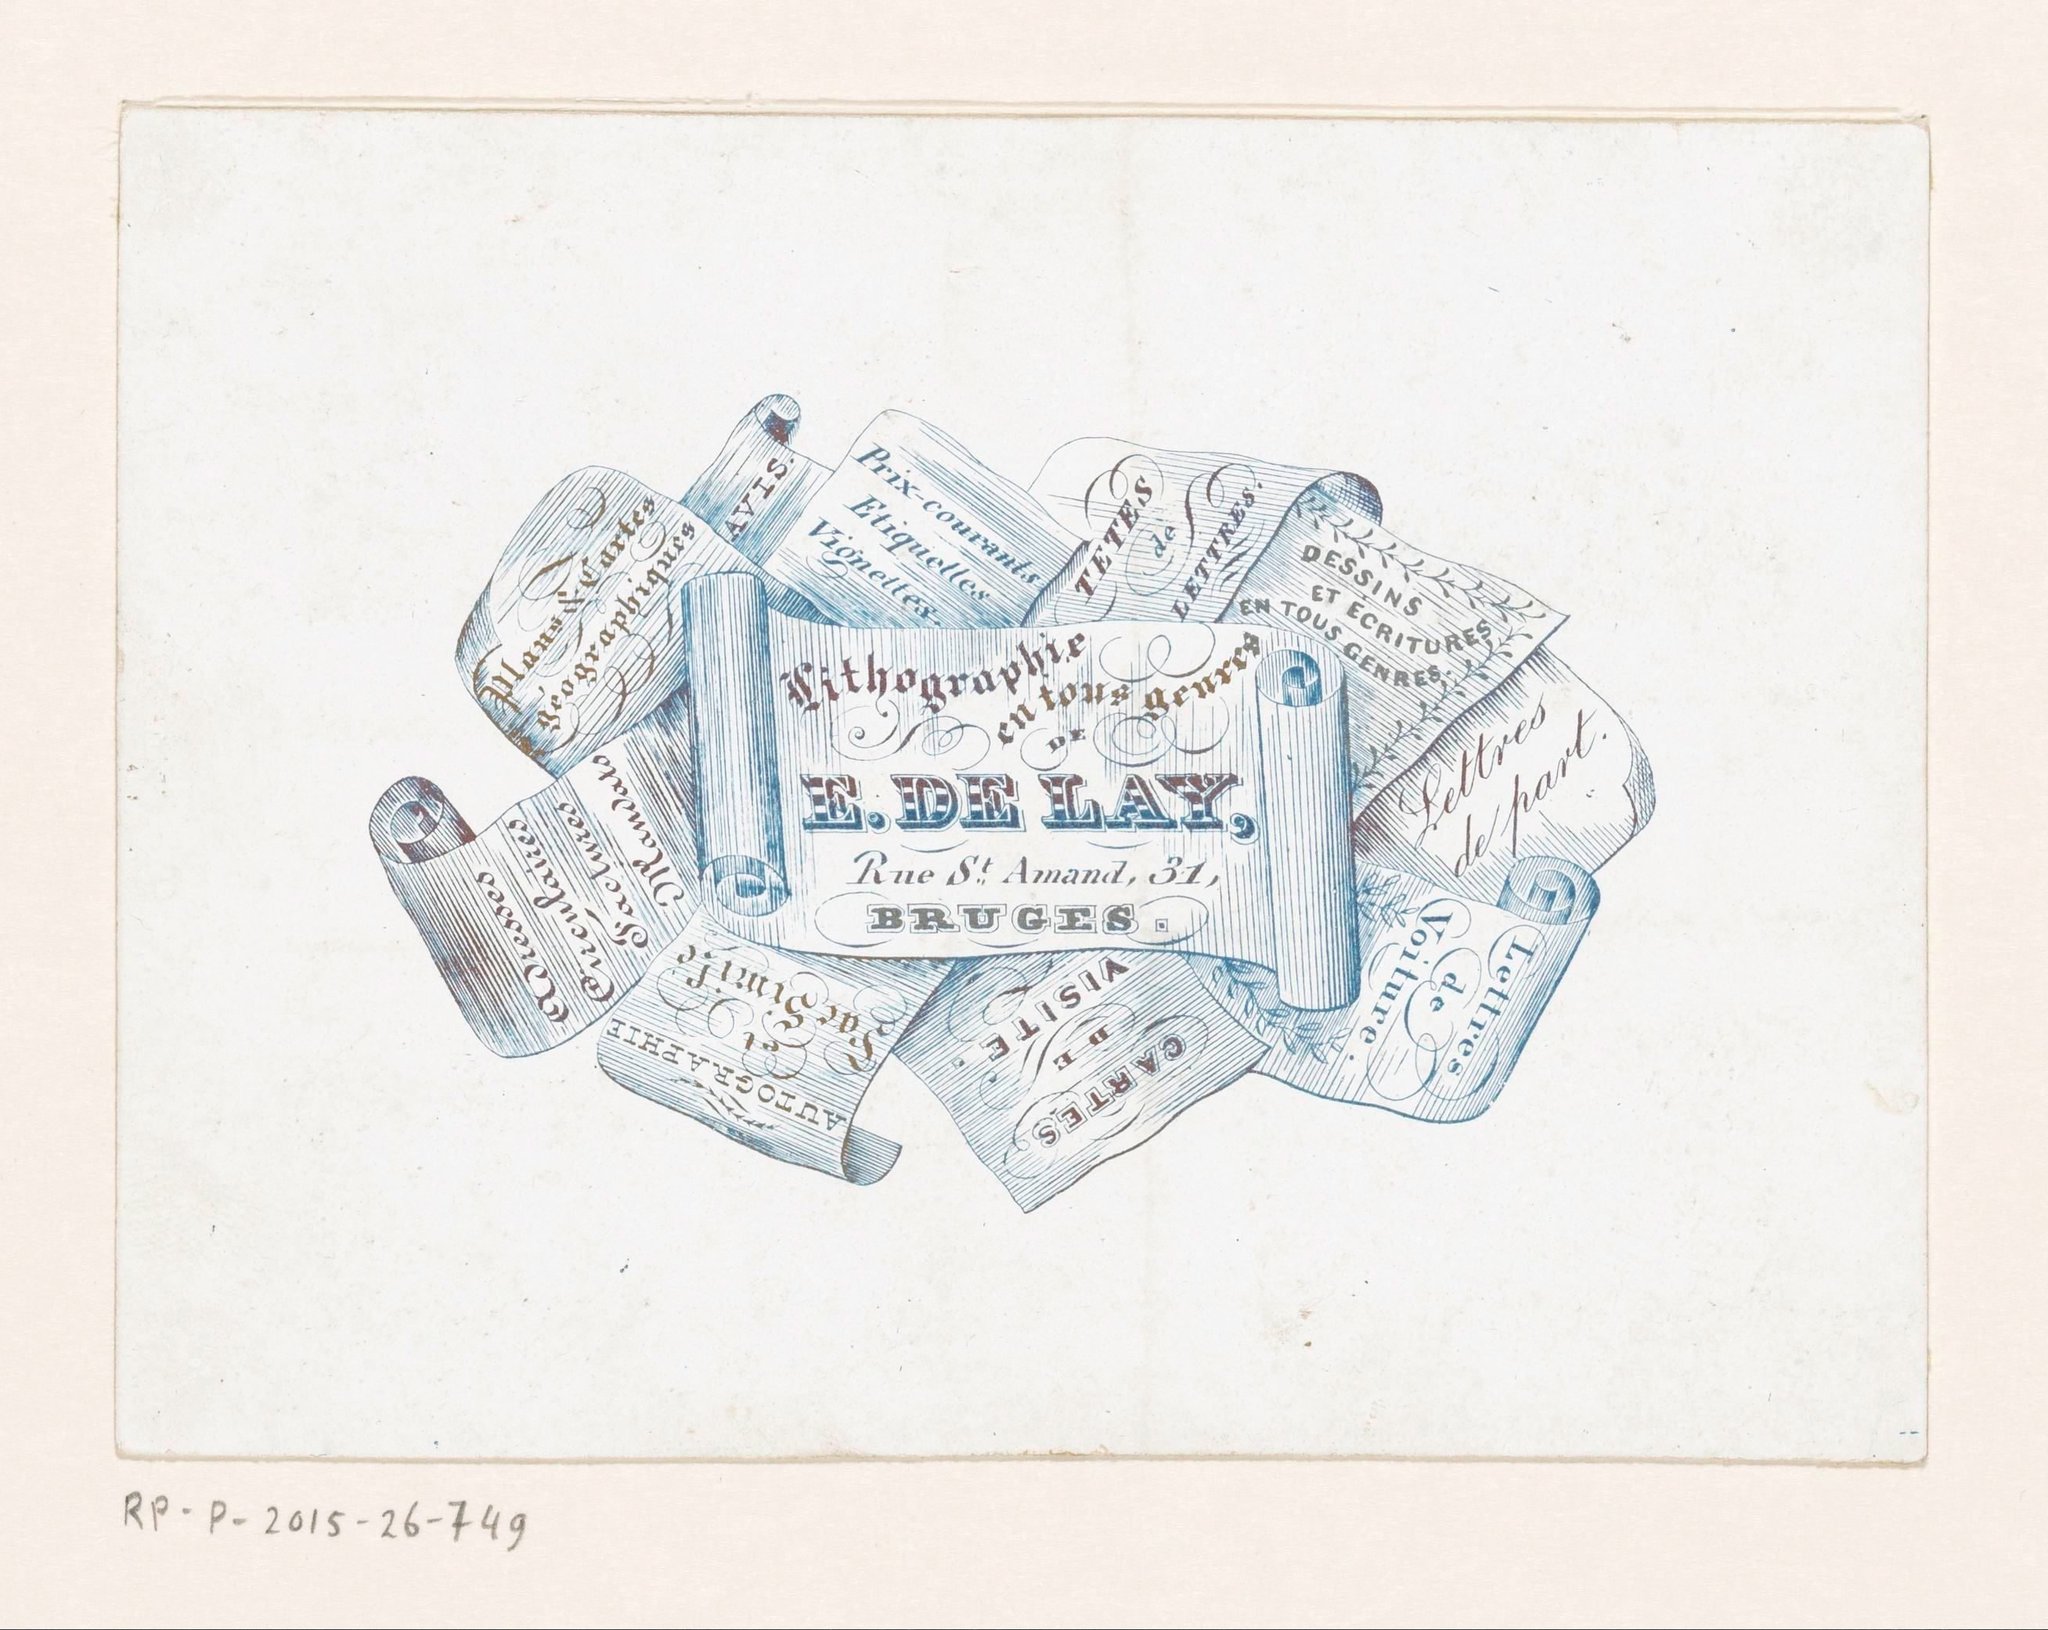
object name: visiting card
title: Visitekaartje van drukker Édouard De Lay-De Muyttere te Brugge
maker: édouard de lay-de muyttere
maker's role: print maker, printer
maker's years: 1816-1857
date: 1842-1855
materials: porcelainized cardboard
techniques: lithograph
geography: bruges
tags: print, e.g.: engraving, etching, lithograph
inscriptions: collector's mark: Lugt 2228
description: Compositie bestaande uit elf bladen met tekst.